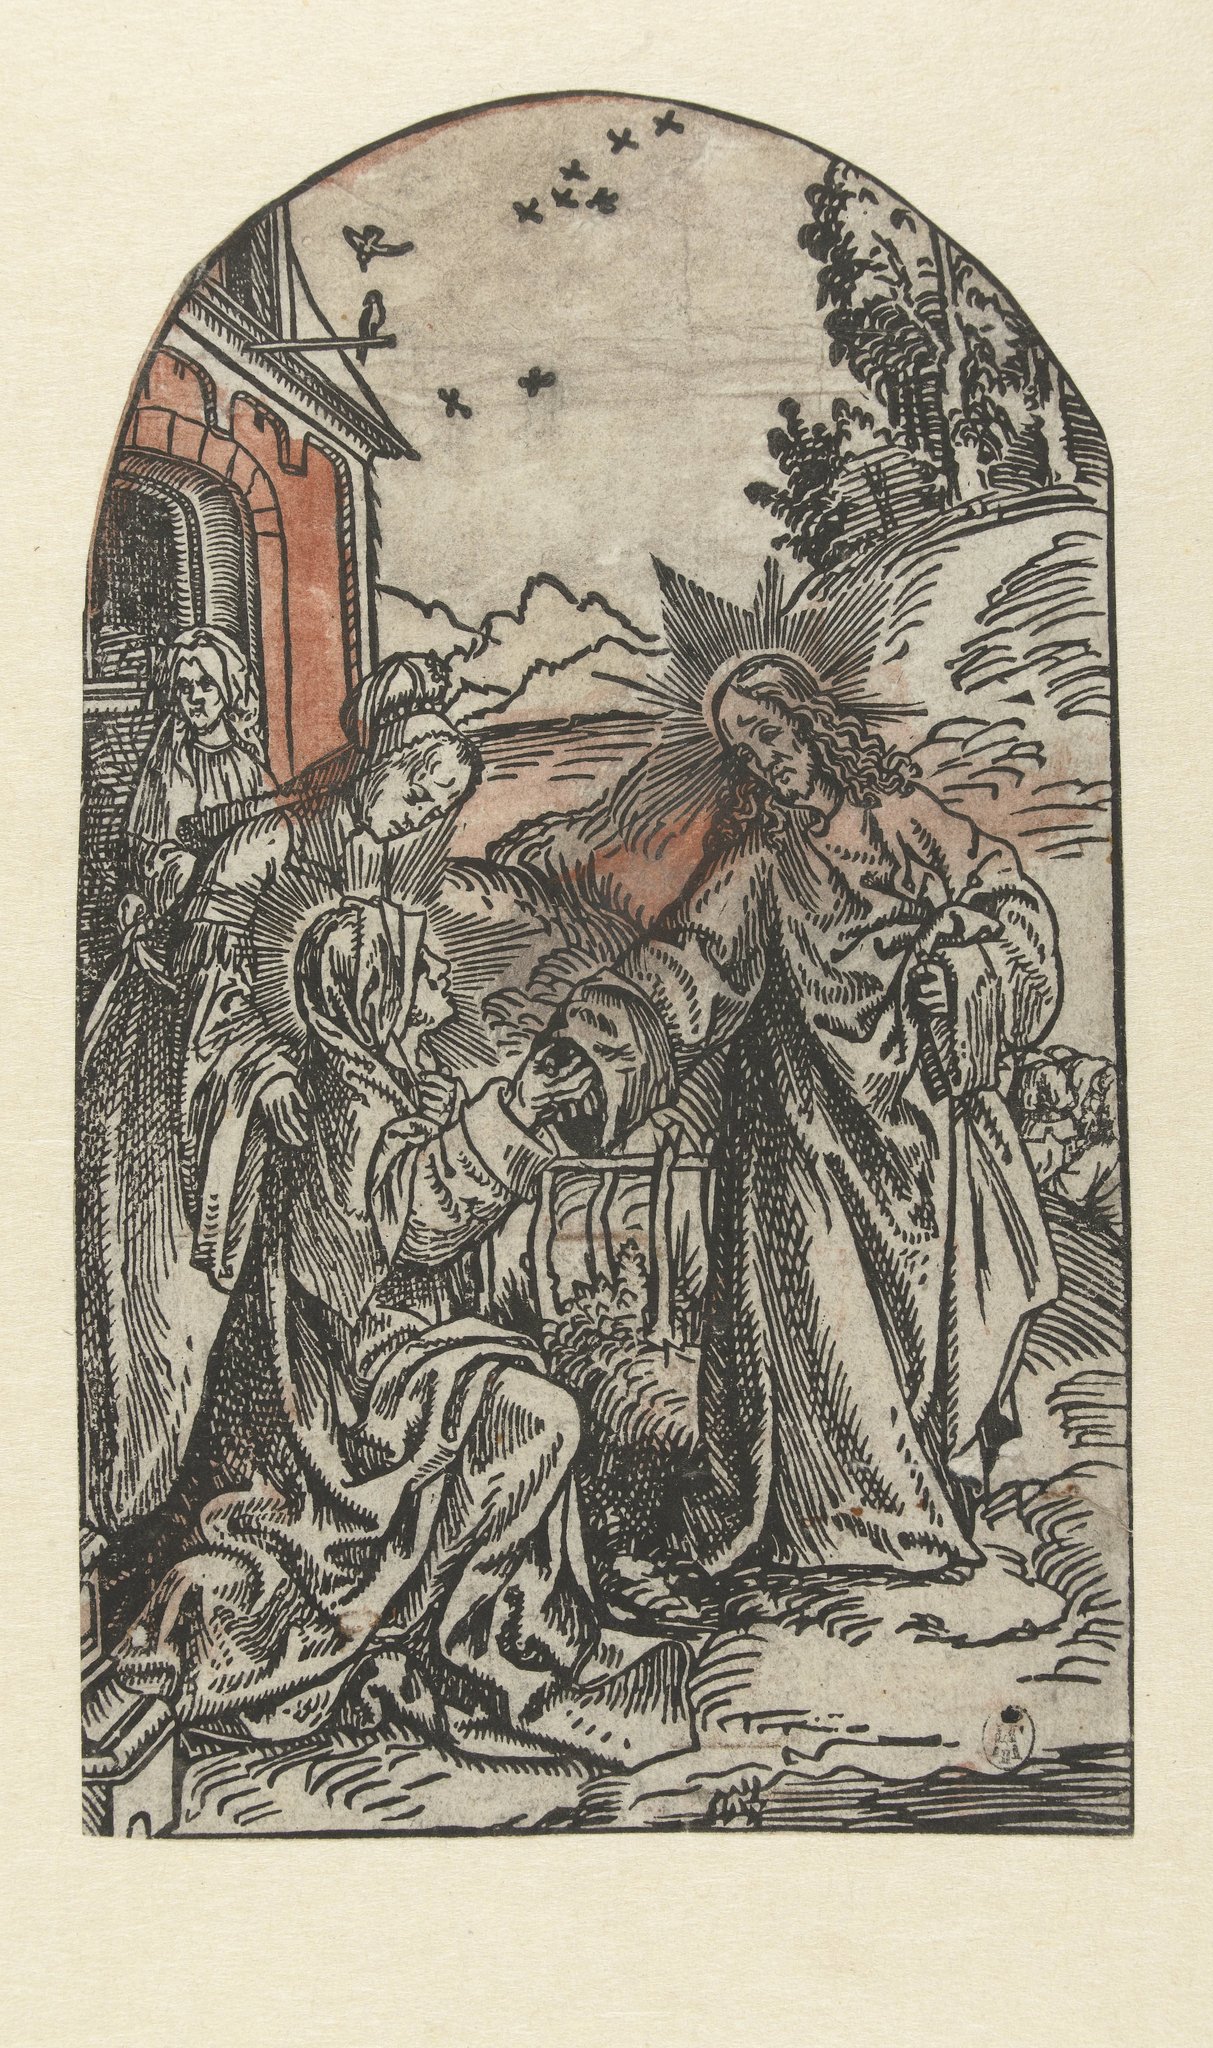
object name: print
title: Christus neemt afscheid van zijn moeder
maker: jacob cornelisz van oostsanen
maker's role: draughtsman, painter, print maker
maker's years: 1475-1533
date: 1507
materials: paper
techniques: woodcut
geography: low countries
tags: christ taking leave of mary, usually mary magdalene present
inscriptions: collector's mark: Lugt 971, collector's mark: Lugt 2228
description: Fragment van een prent met vier voorstellingen uit een serie van zeven. Maria begeleid door een vrouw, knielt en houdt de hand van Christus vast.